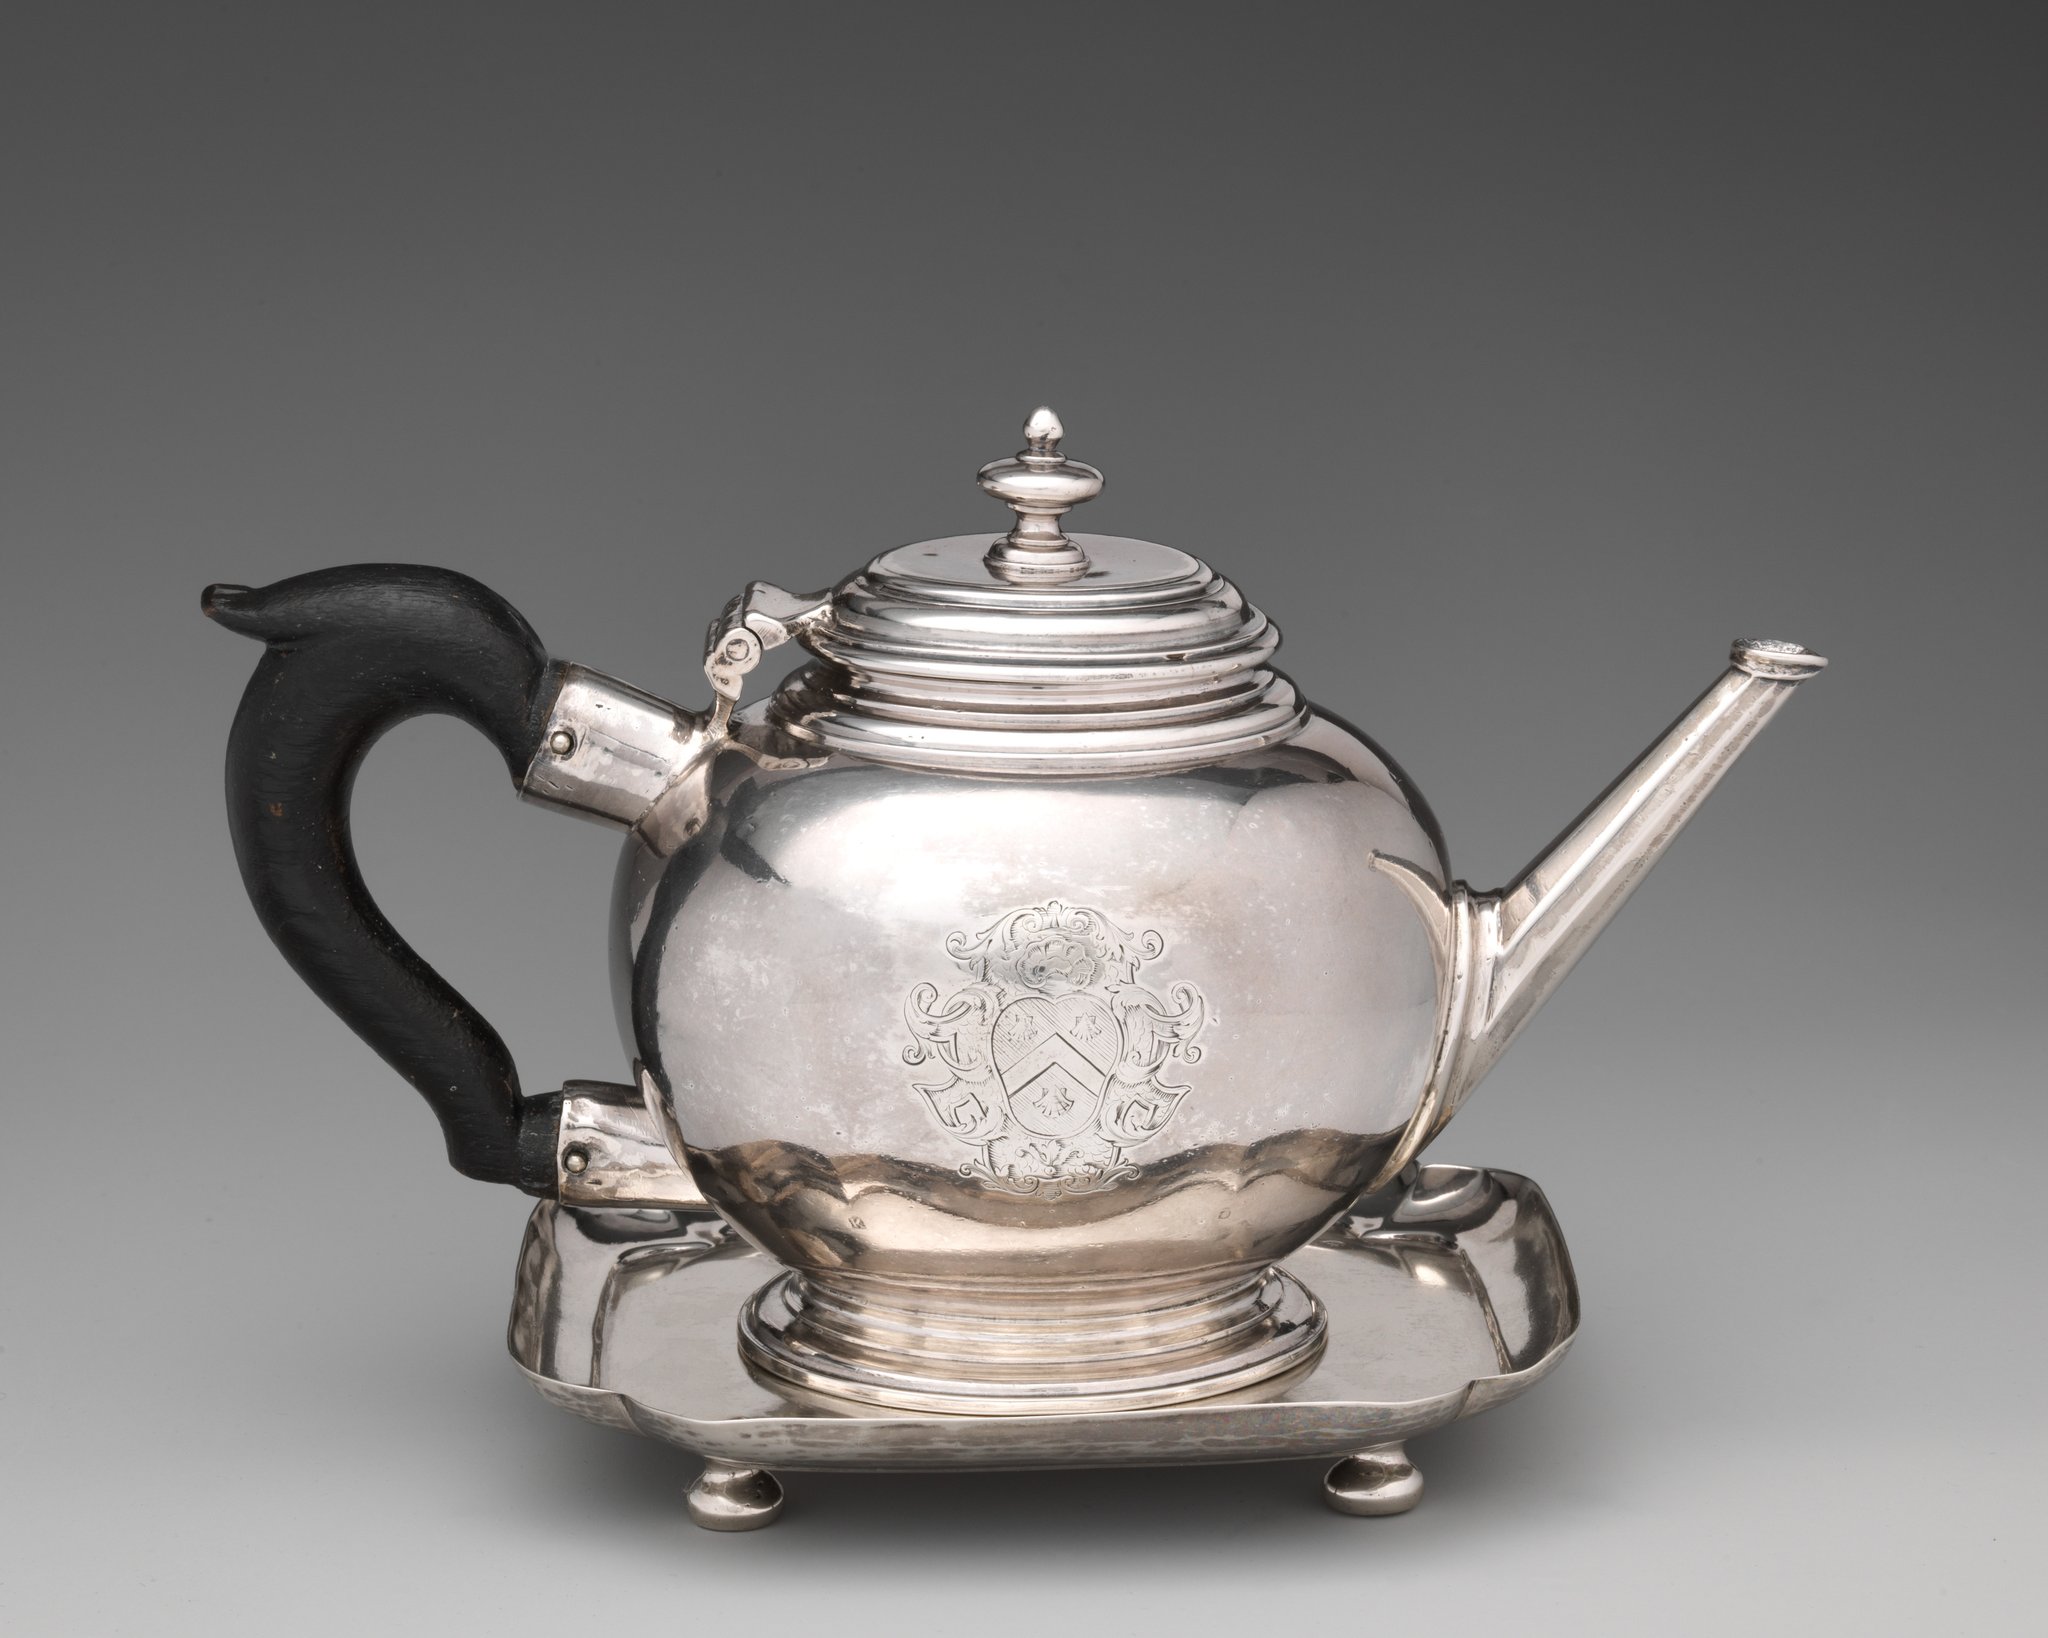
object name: teapot tray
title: Teapot and tray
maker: bowles nash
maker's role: maker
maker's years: 1720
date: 1725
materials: silver, wood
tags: coat of arms